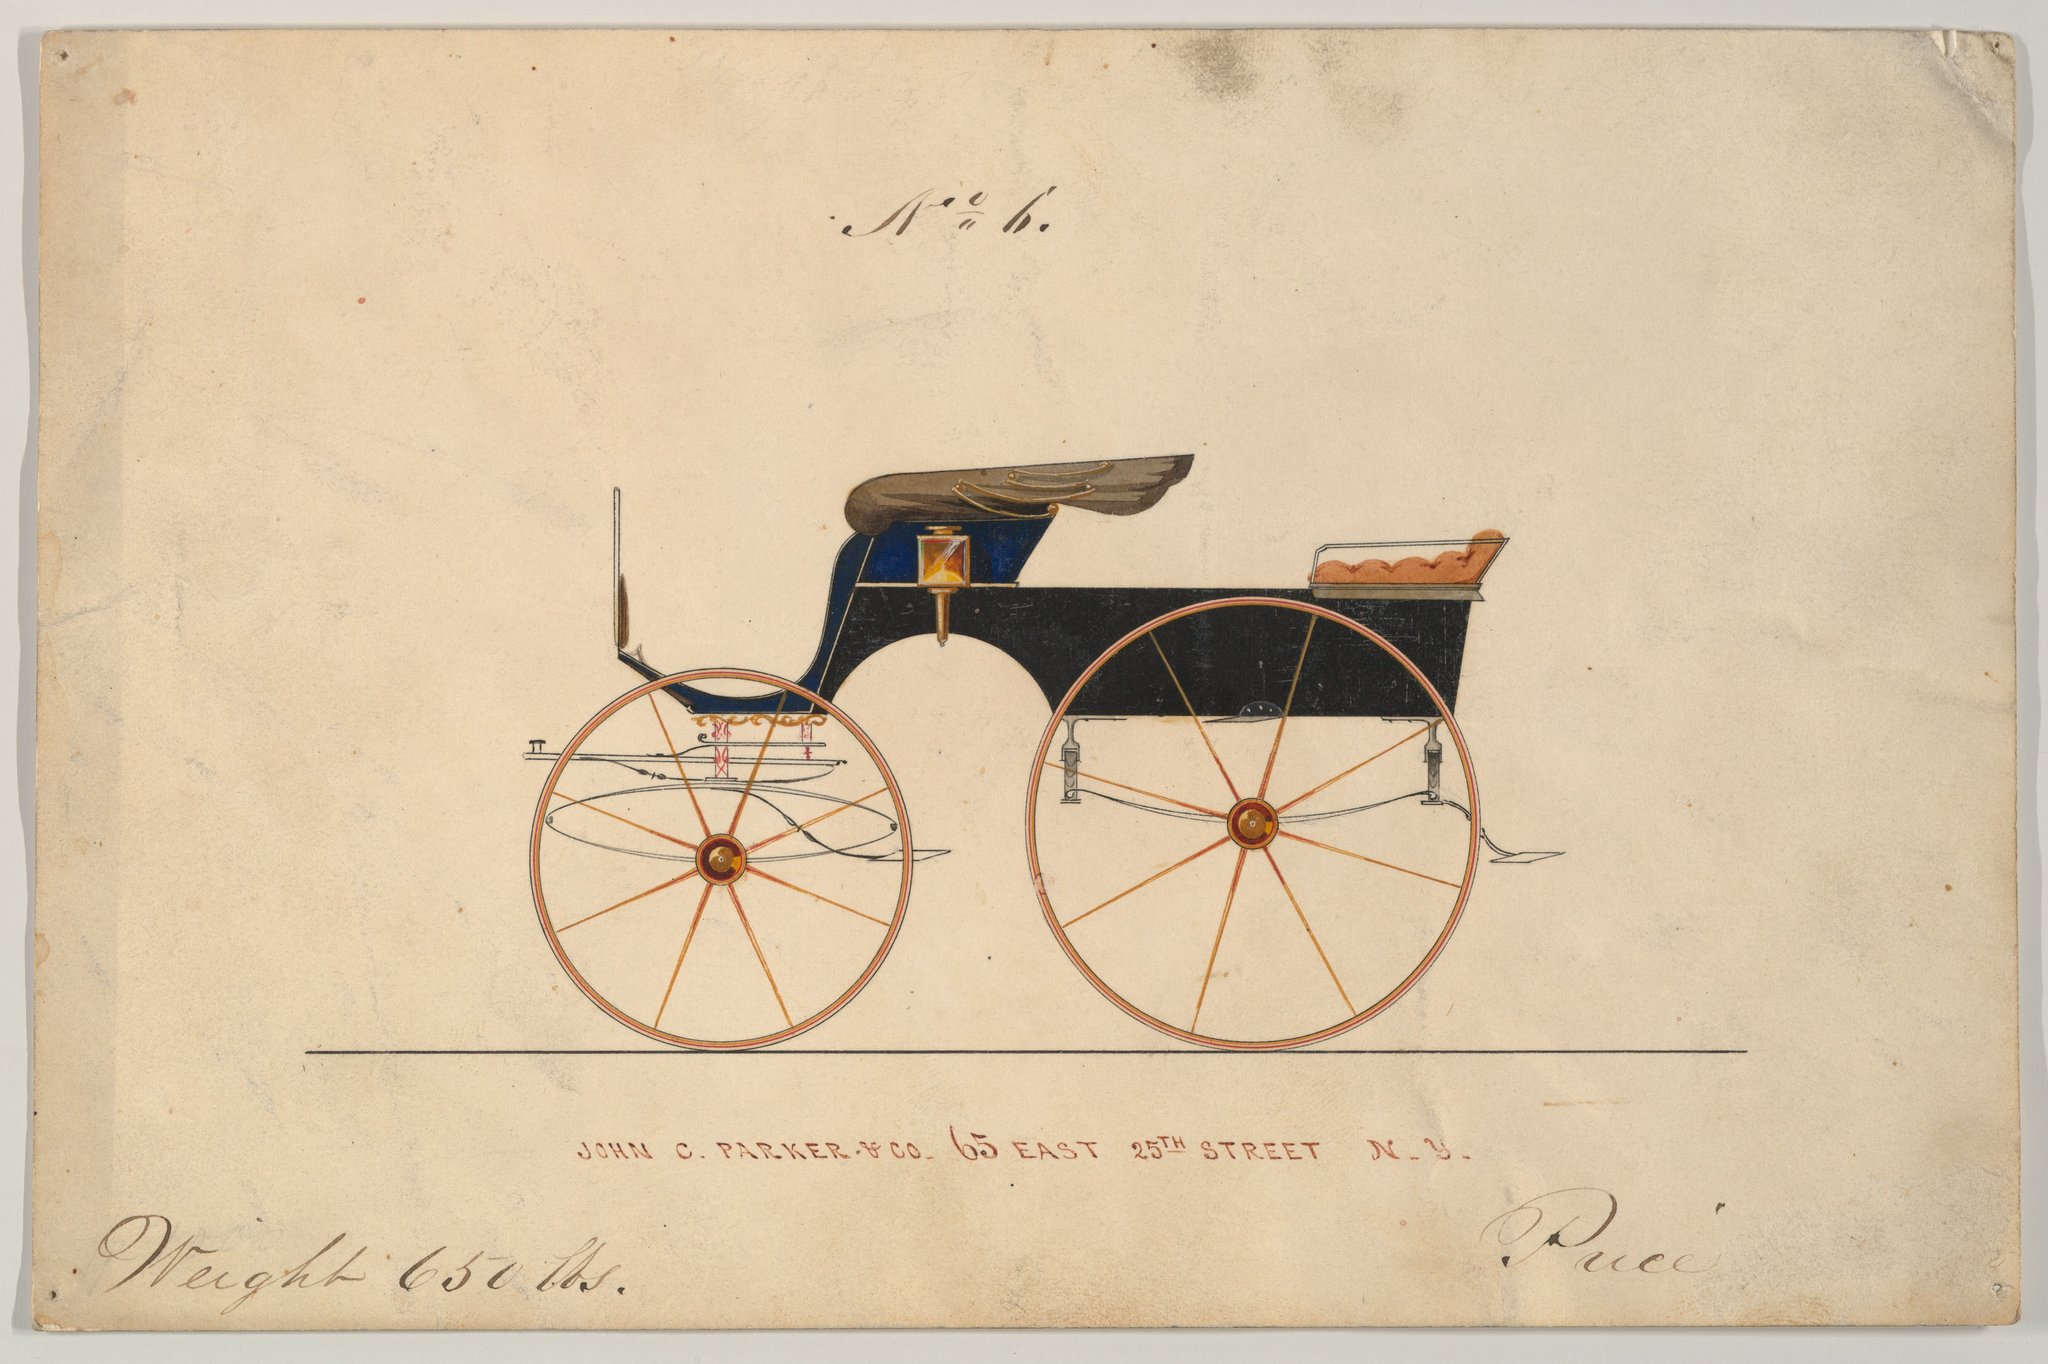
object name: drawing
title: Design for Phaeton, no. 6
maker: john c. parker & co.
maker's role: manufacturer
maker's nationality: american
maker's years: 1800-1900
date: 1875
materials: gouache, gum arabic, ink, watercolor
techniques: pen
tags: carriages